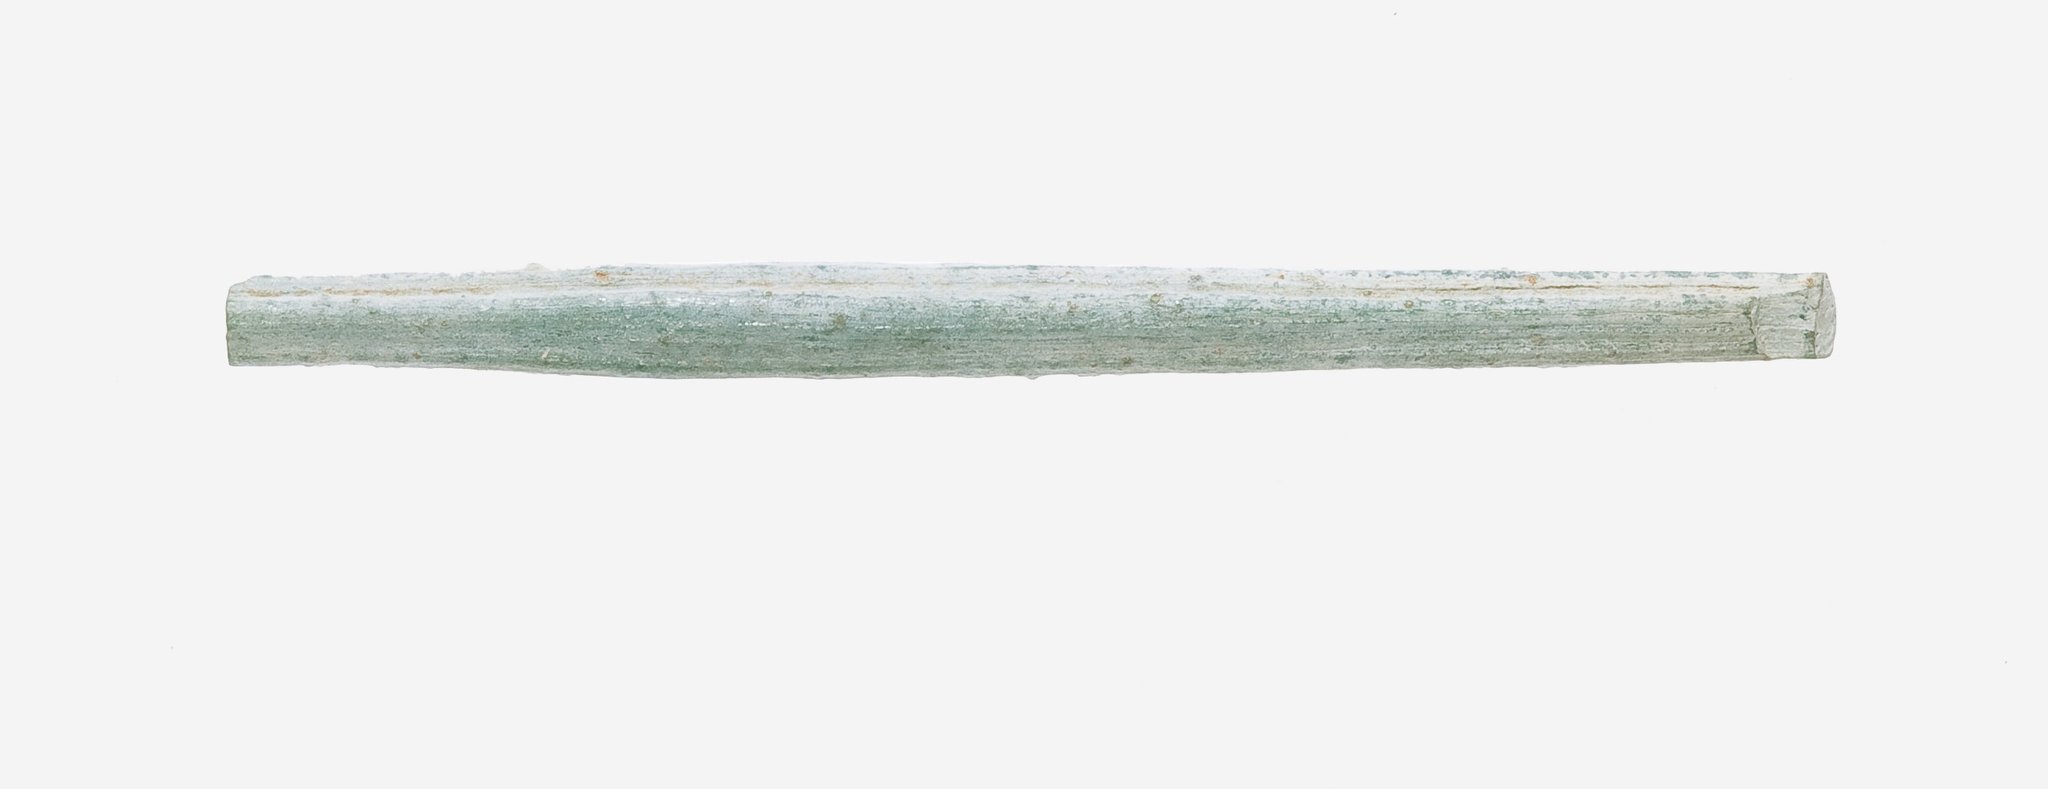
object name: glass rod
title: Glass Rods Fused Together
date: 1390-1352 BCE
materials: glass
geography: egypt